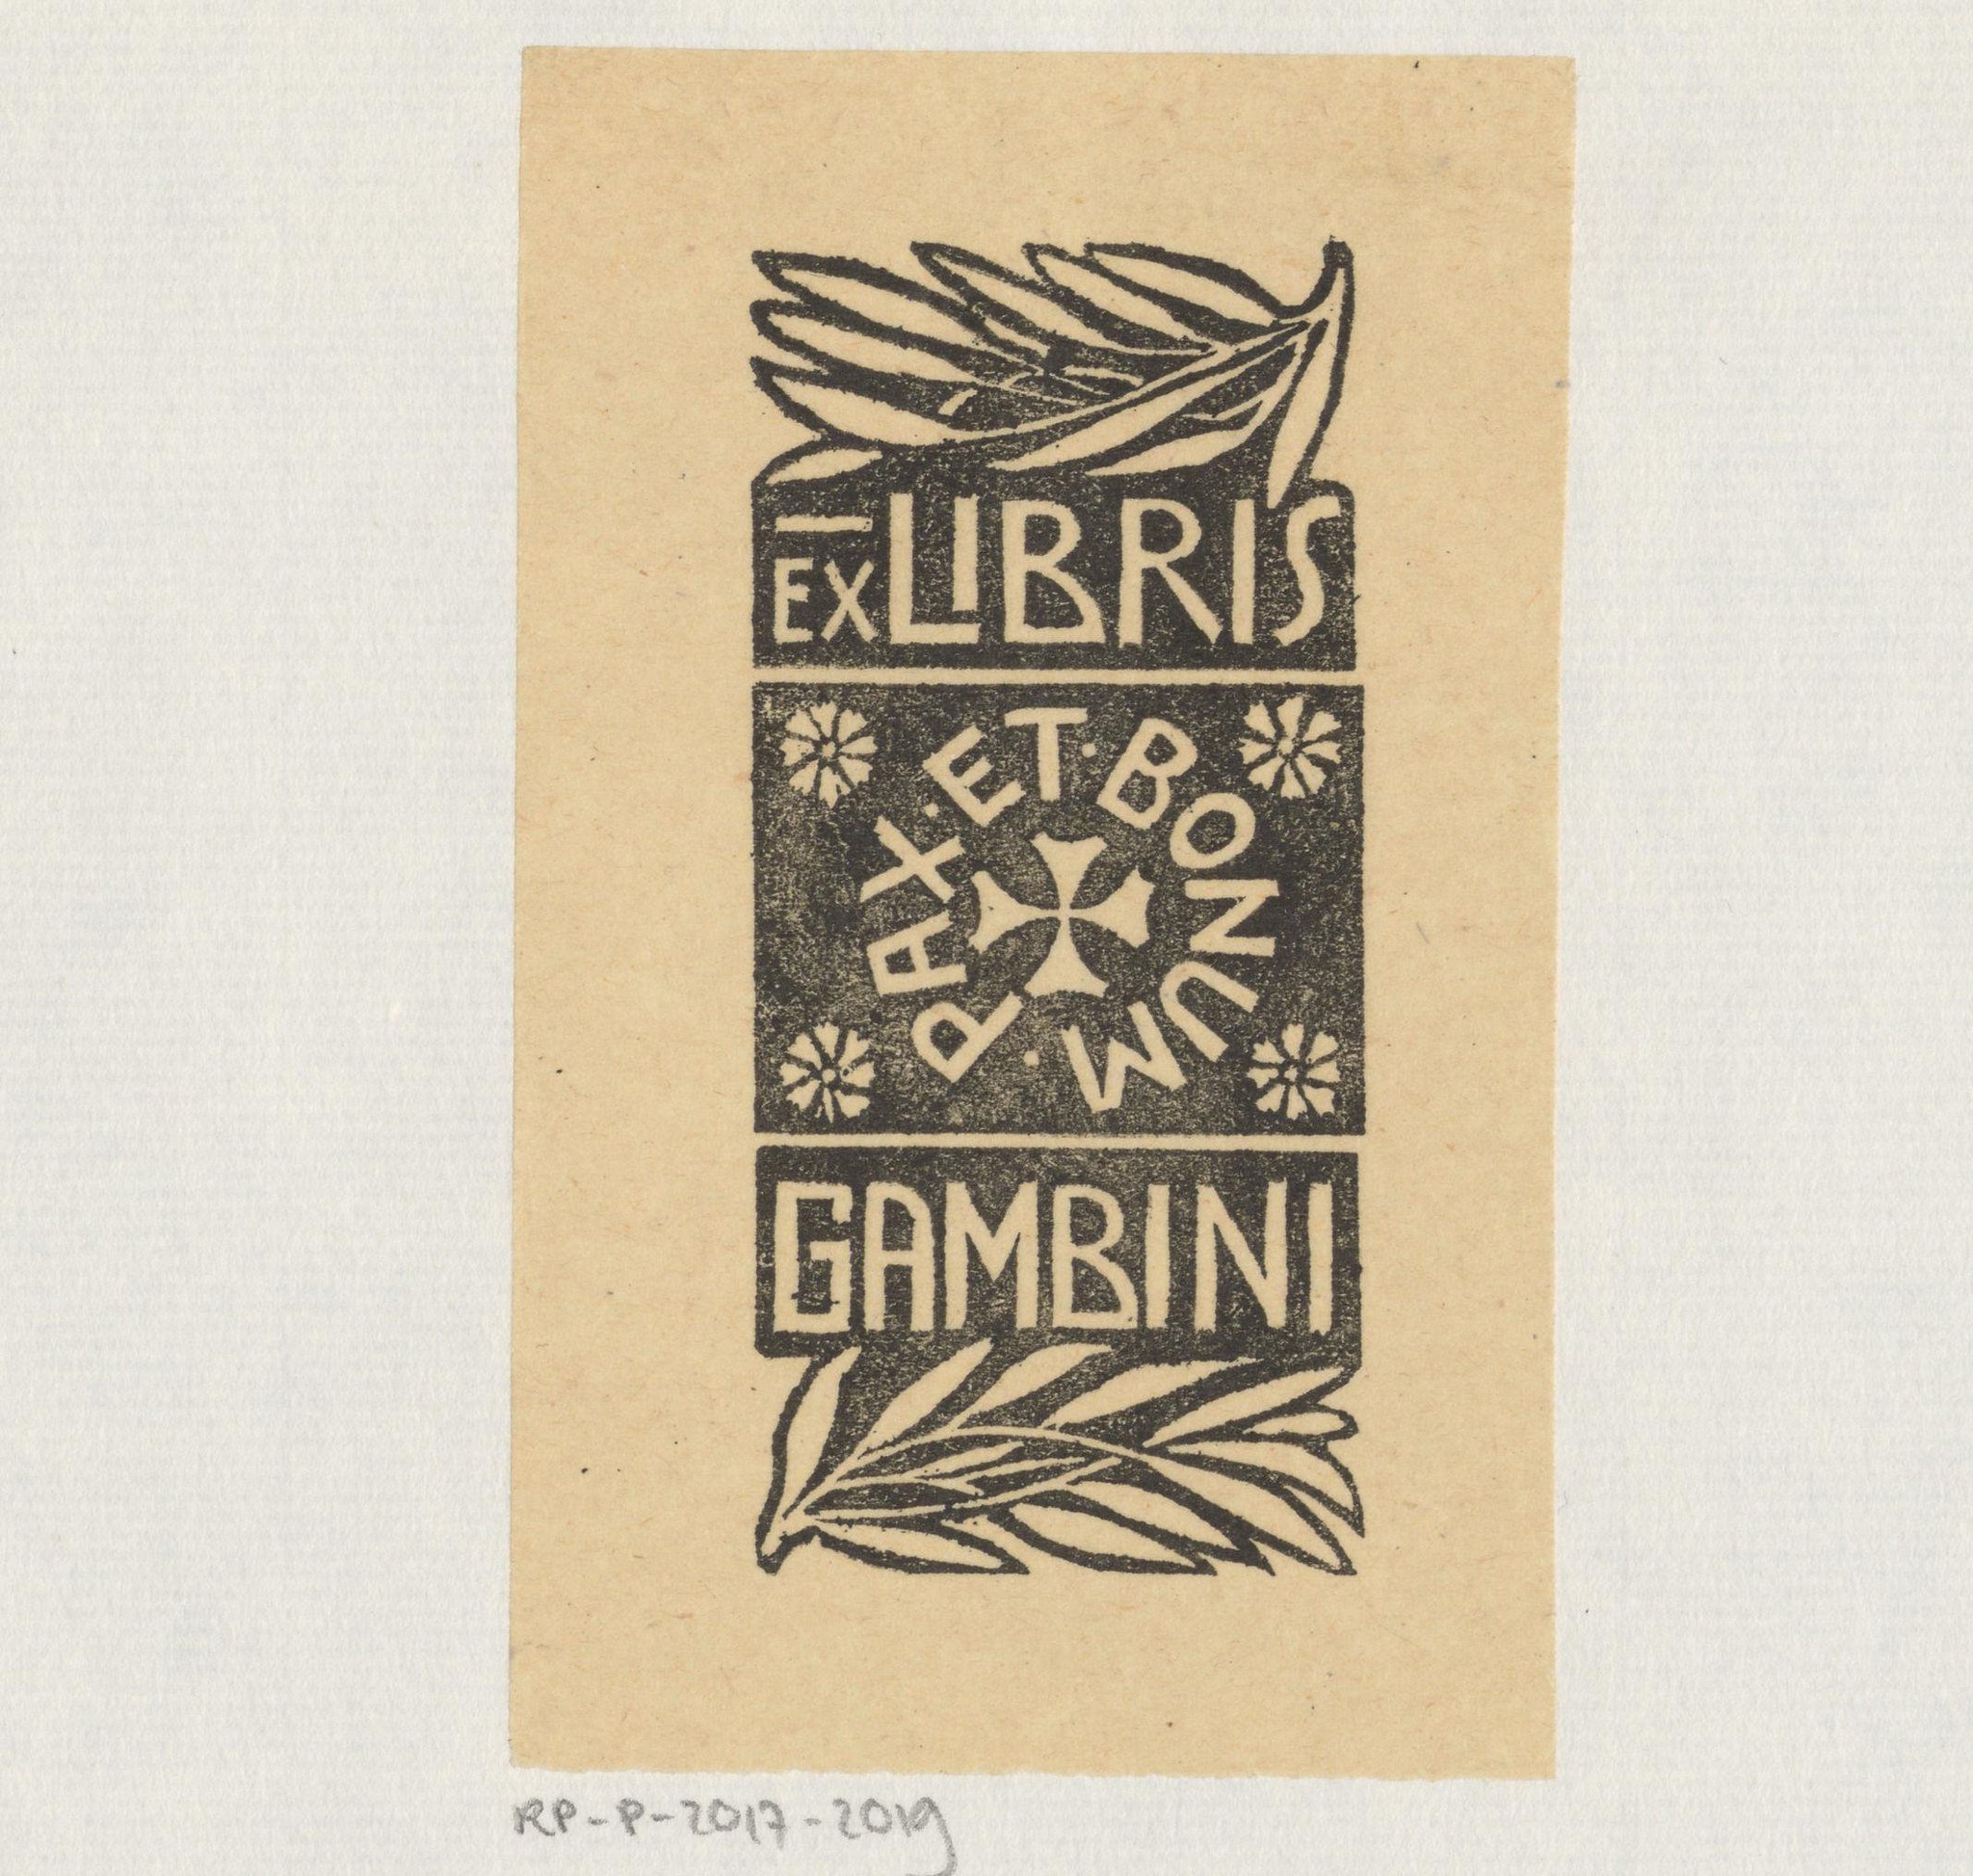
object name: bookplate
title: Ex libris van Gambini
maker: iörg gambini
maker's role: print maker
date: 1930-1950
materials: paper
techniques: linocut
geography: italy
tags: print maker, iörg gambini, symbols, allegories of peace, 'pax'; 'pace' (ripa), trees: palm-tree